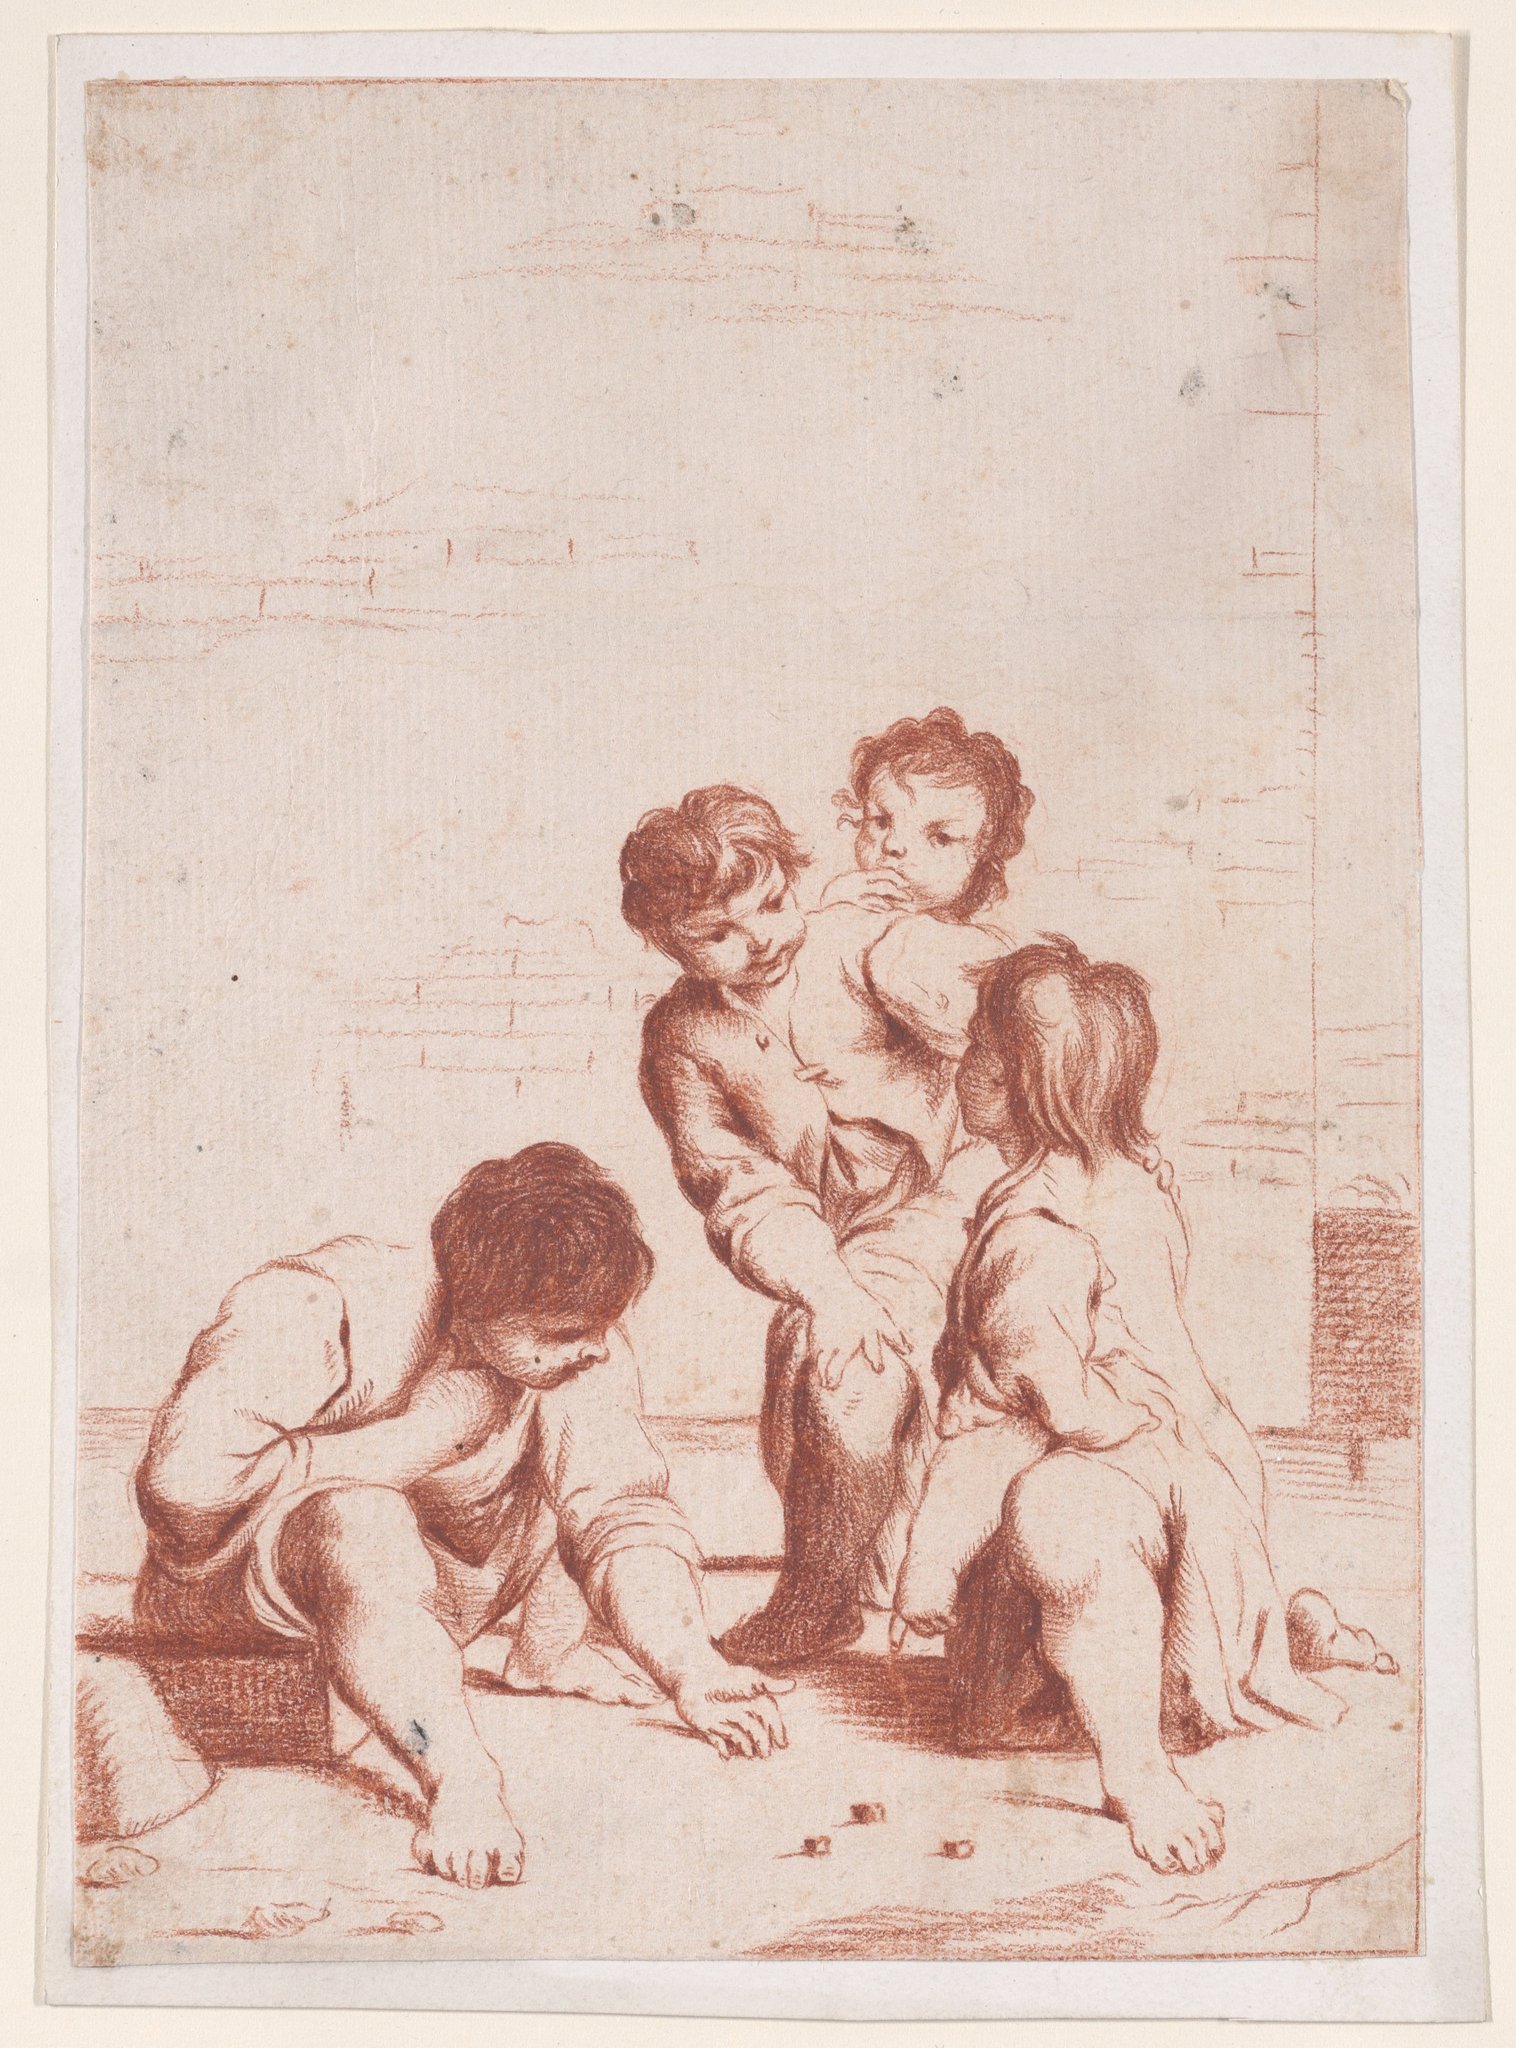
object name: drawing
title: Four children playing with dice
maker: Anonymous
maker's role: artist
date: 1701-1800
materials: chalk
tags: boys,dice,playing